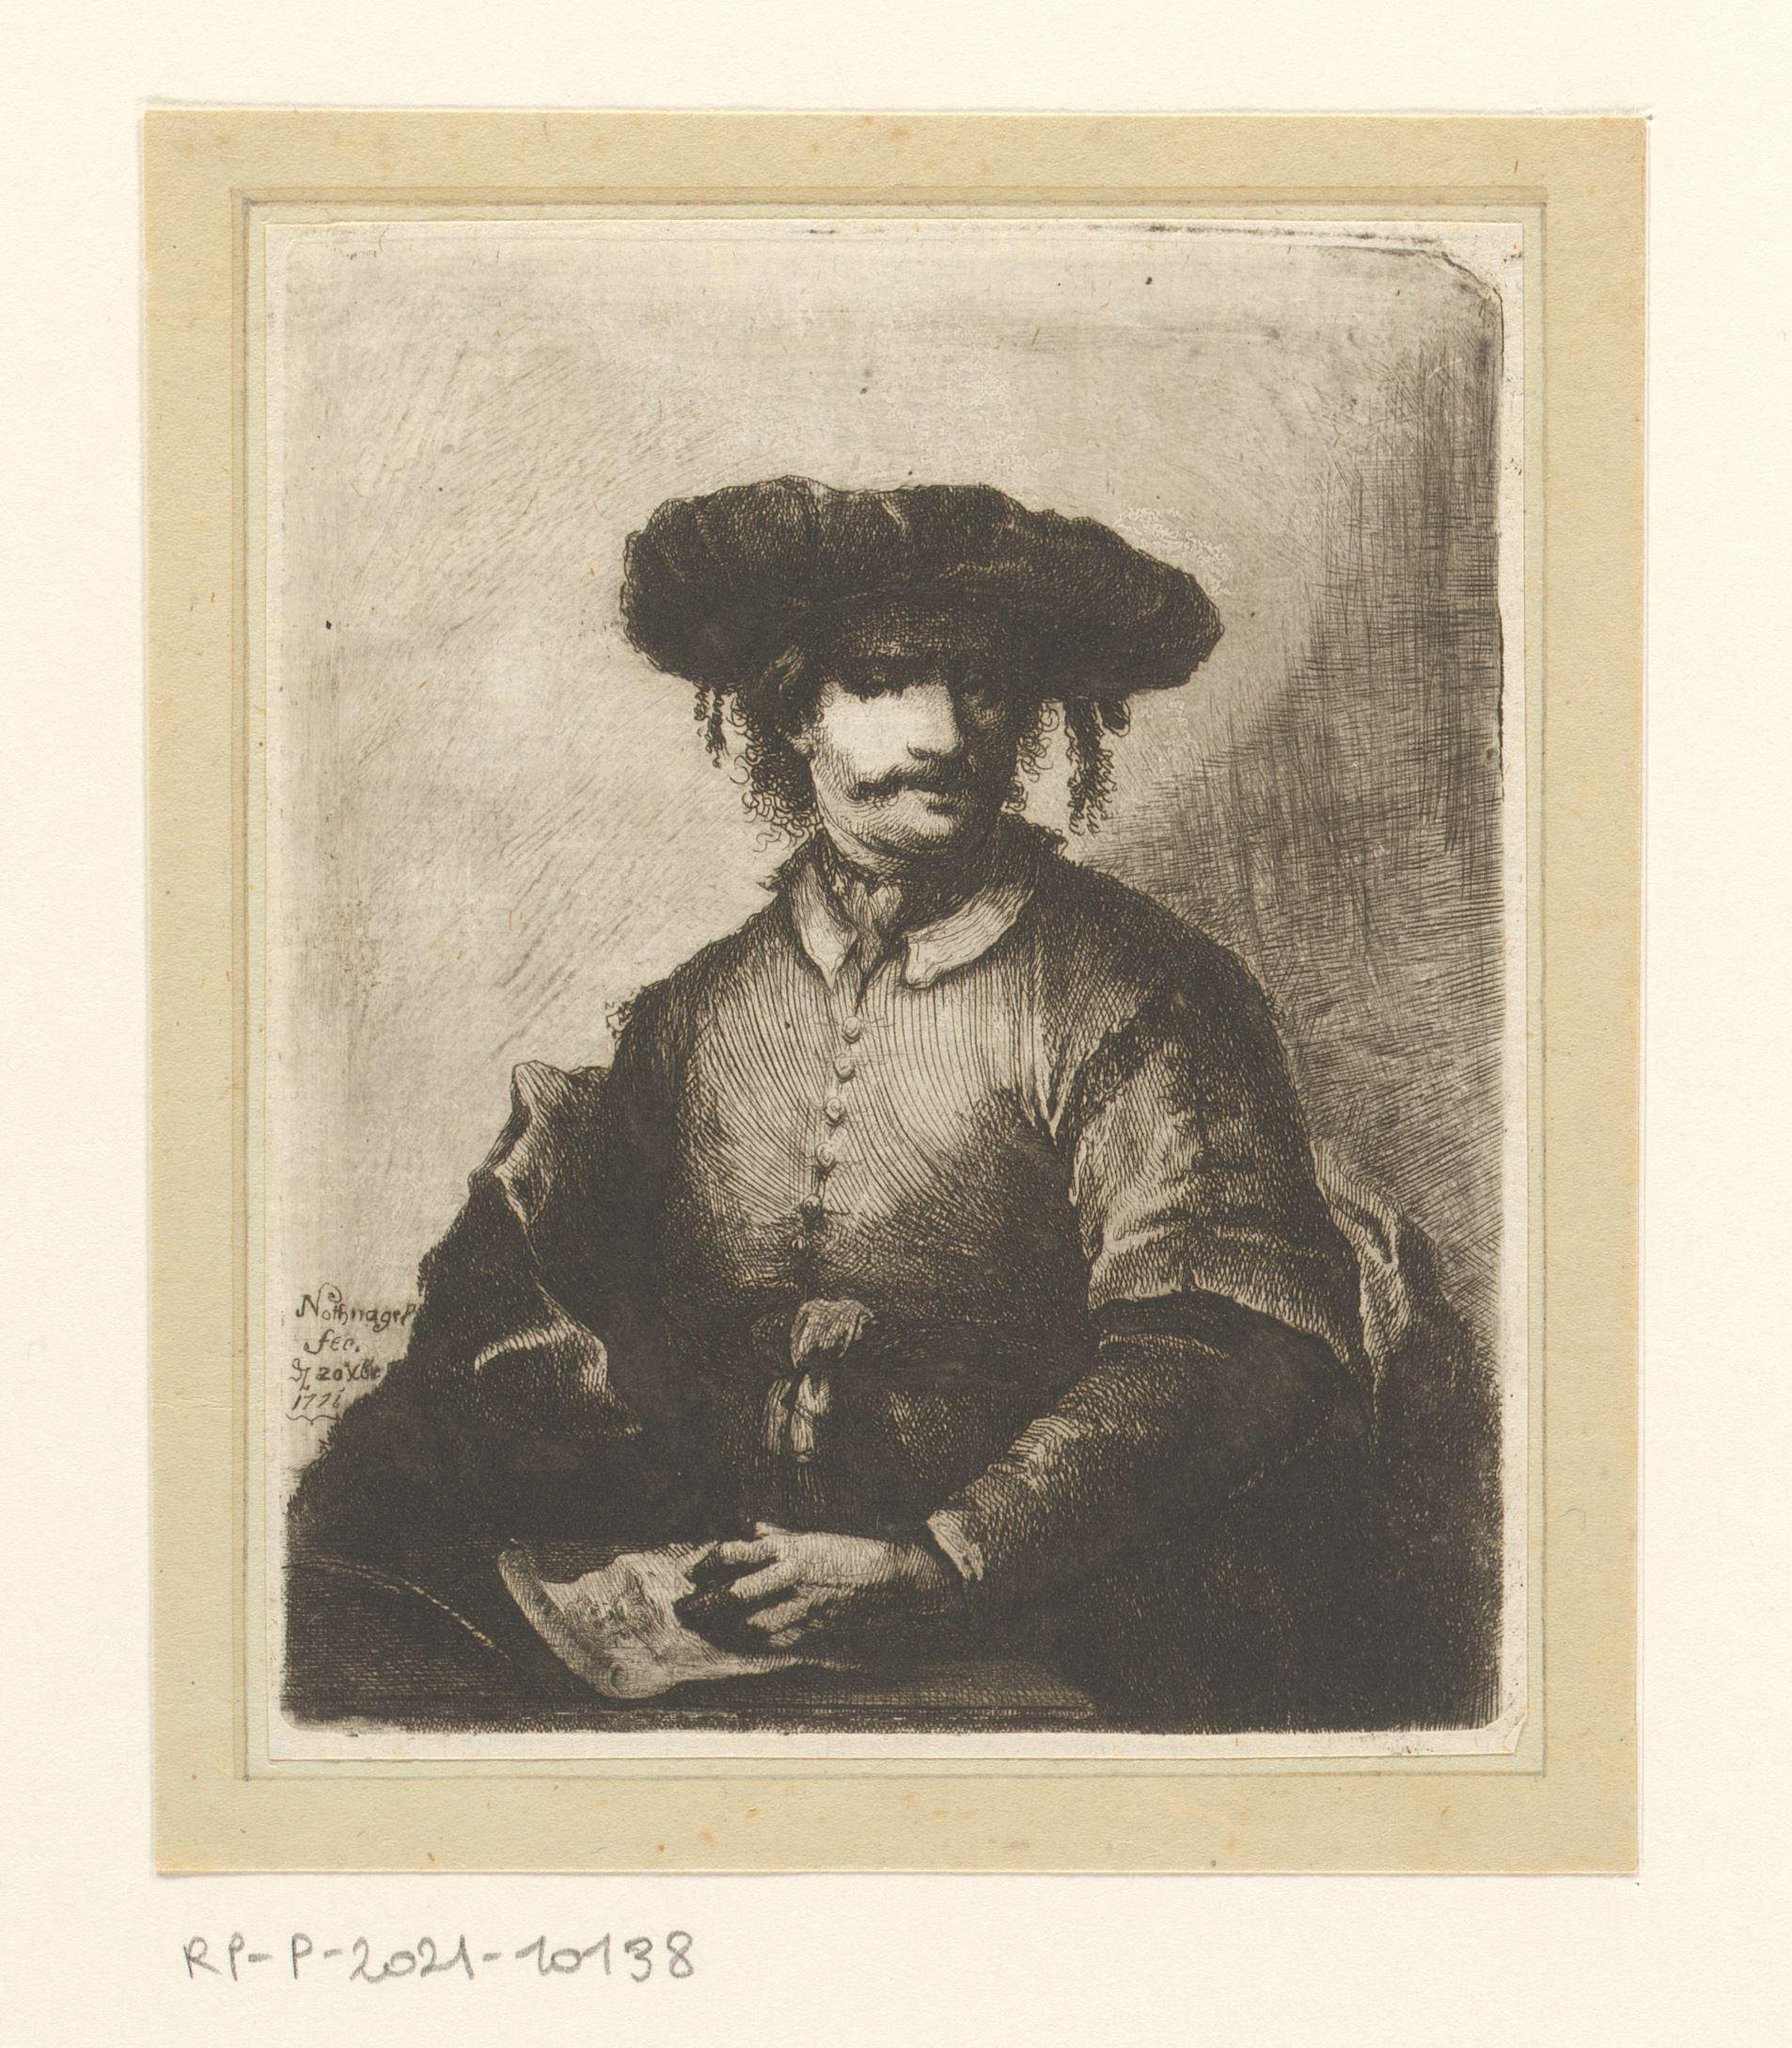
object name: print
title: Portret van een onbekende kunstenaar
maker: johann andreas benjamin nothnagel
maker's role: print maker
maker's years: 1729-1804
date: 1771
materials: paper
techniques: drypoint, etching, intaglio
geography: germany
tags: drawing, sketch, anonymous historical person portrayed alone, portrait, self-portrait of artist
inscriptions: collector's mark: Lugt 2028, inscription: ‘Johann Nothnagel (geb. 1729)/ Bekend als imitator van/ Rembrandt-etsen.’